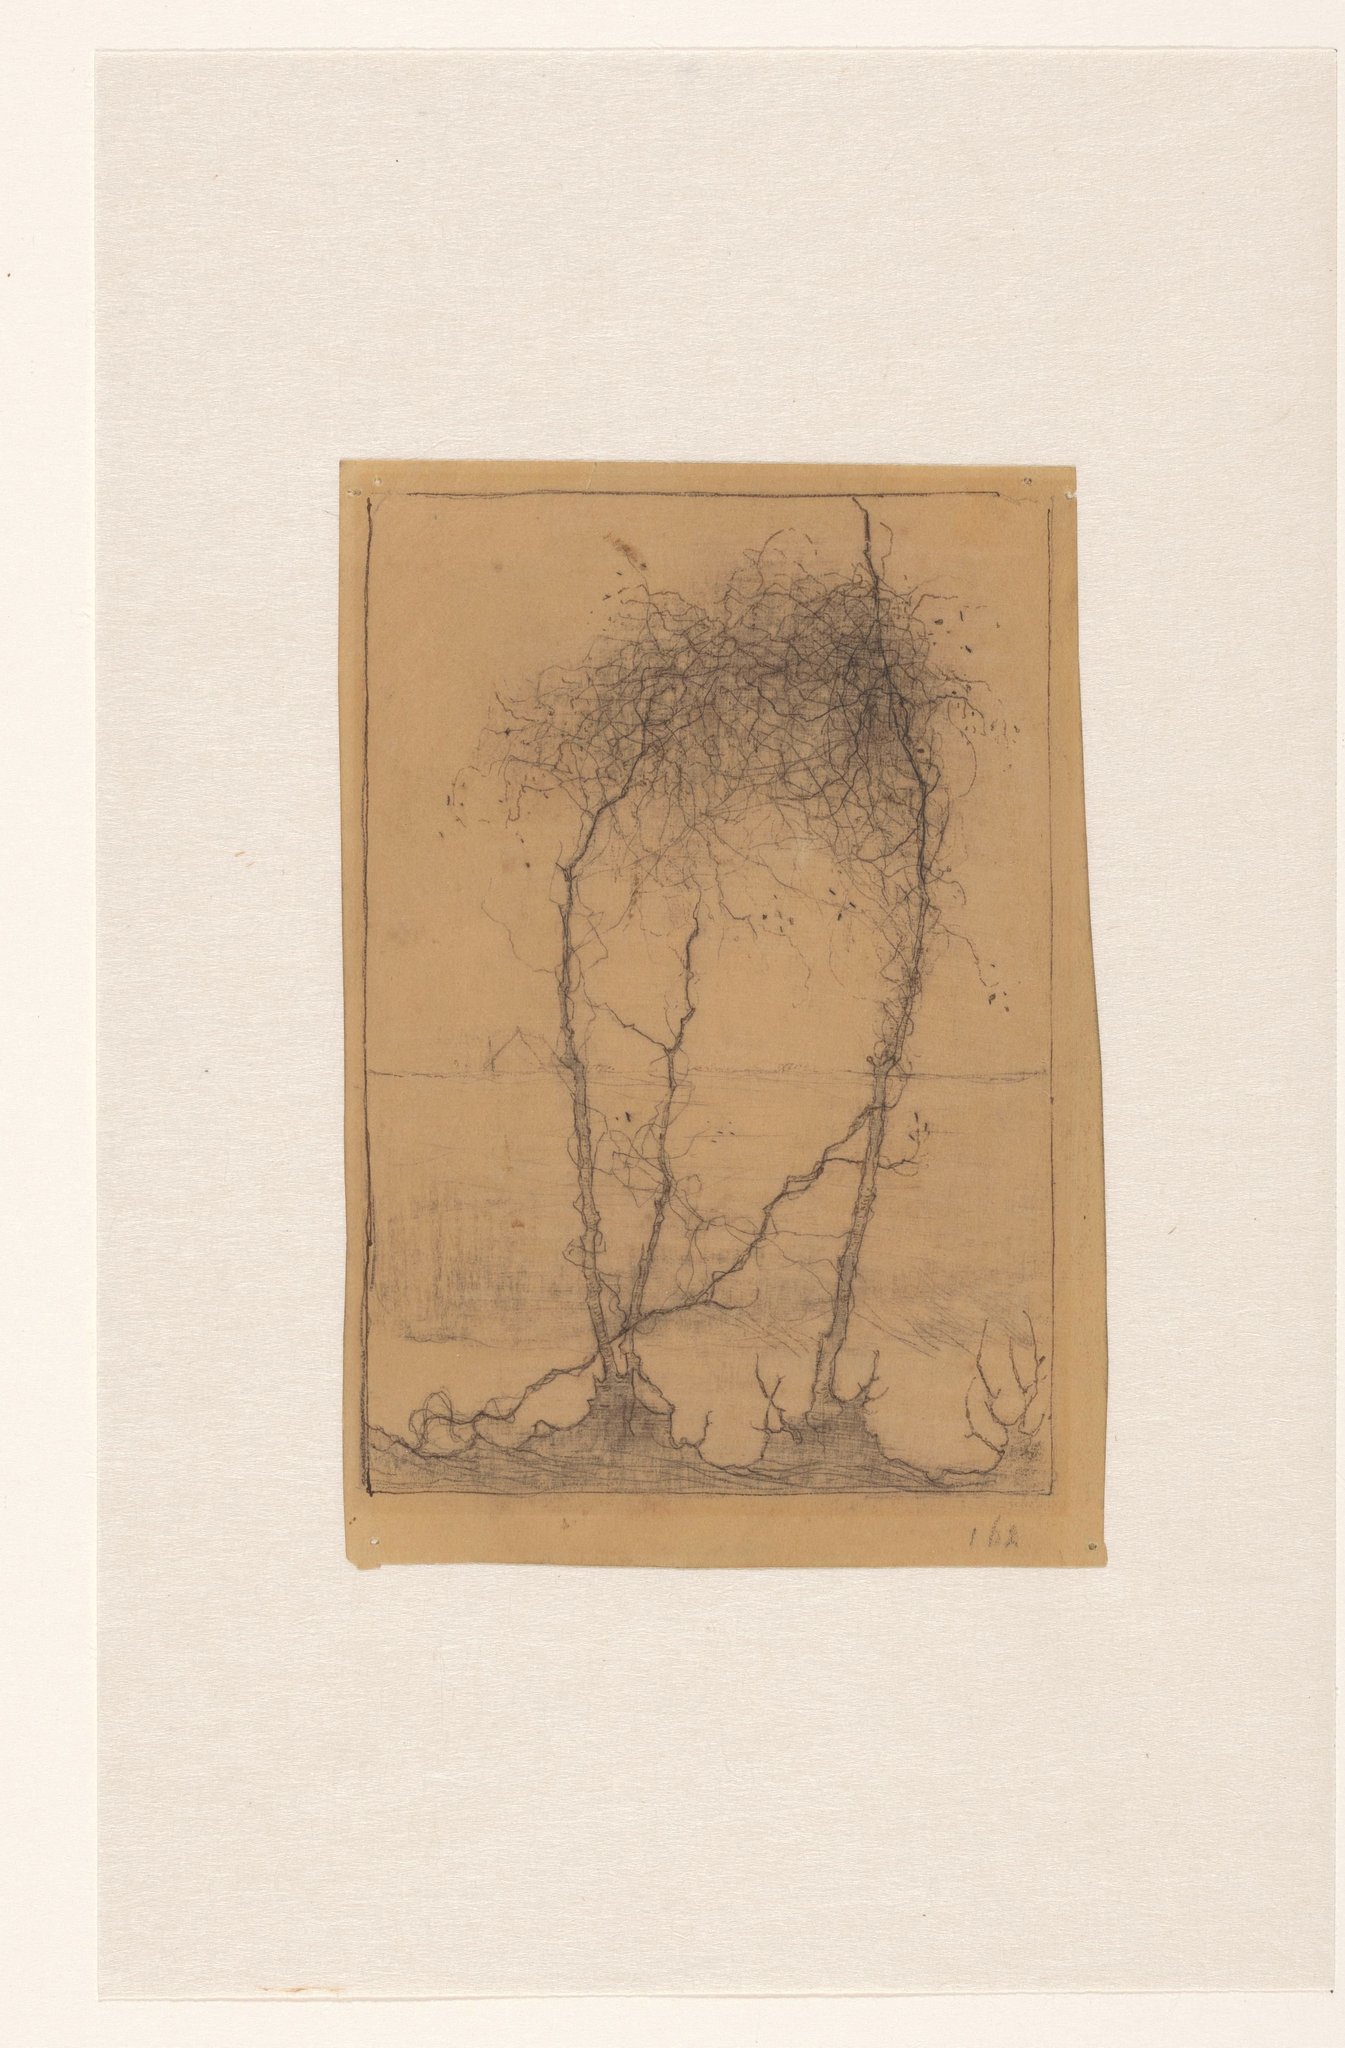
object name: drawing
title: Drie omrankte boomstammetjes aan het water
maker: jan mankes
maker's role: draughtsman, painter, print maker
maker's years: 1889-1920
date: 1899-1920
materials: chalk, paper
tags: trees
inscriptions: collector's mark: Lugt 2228